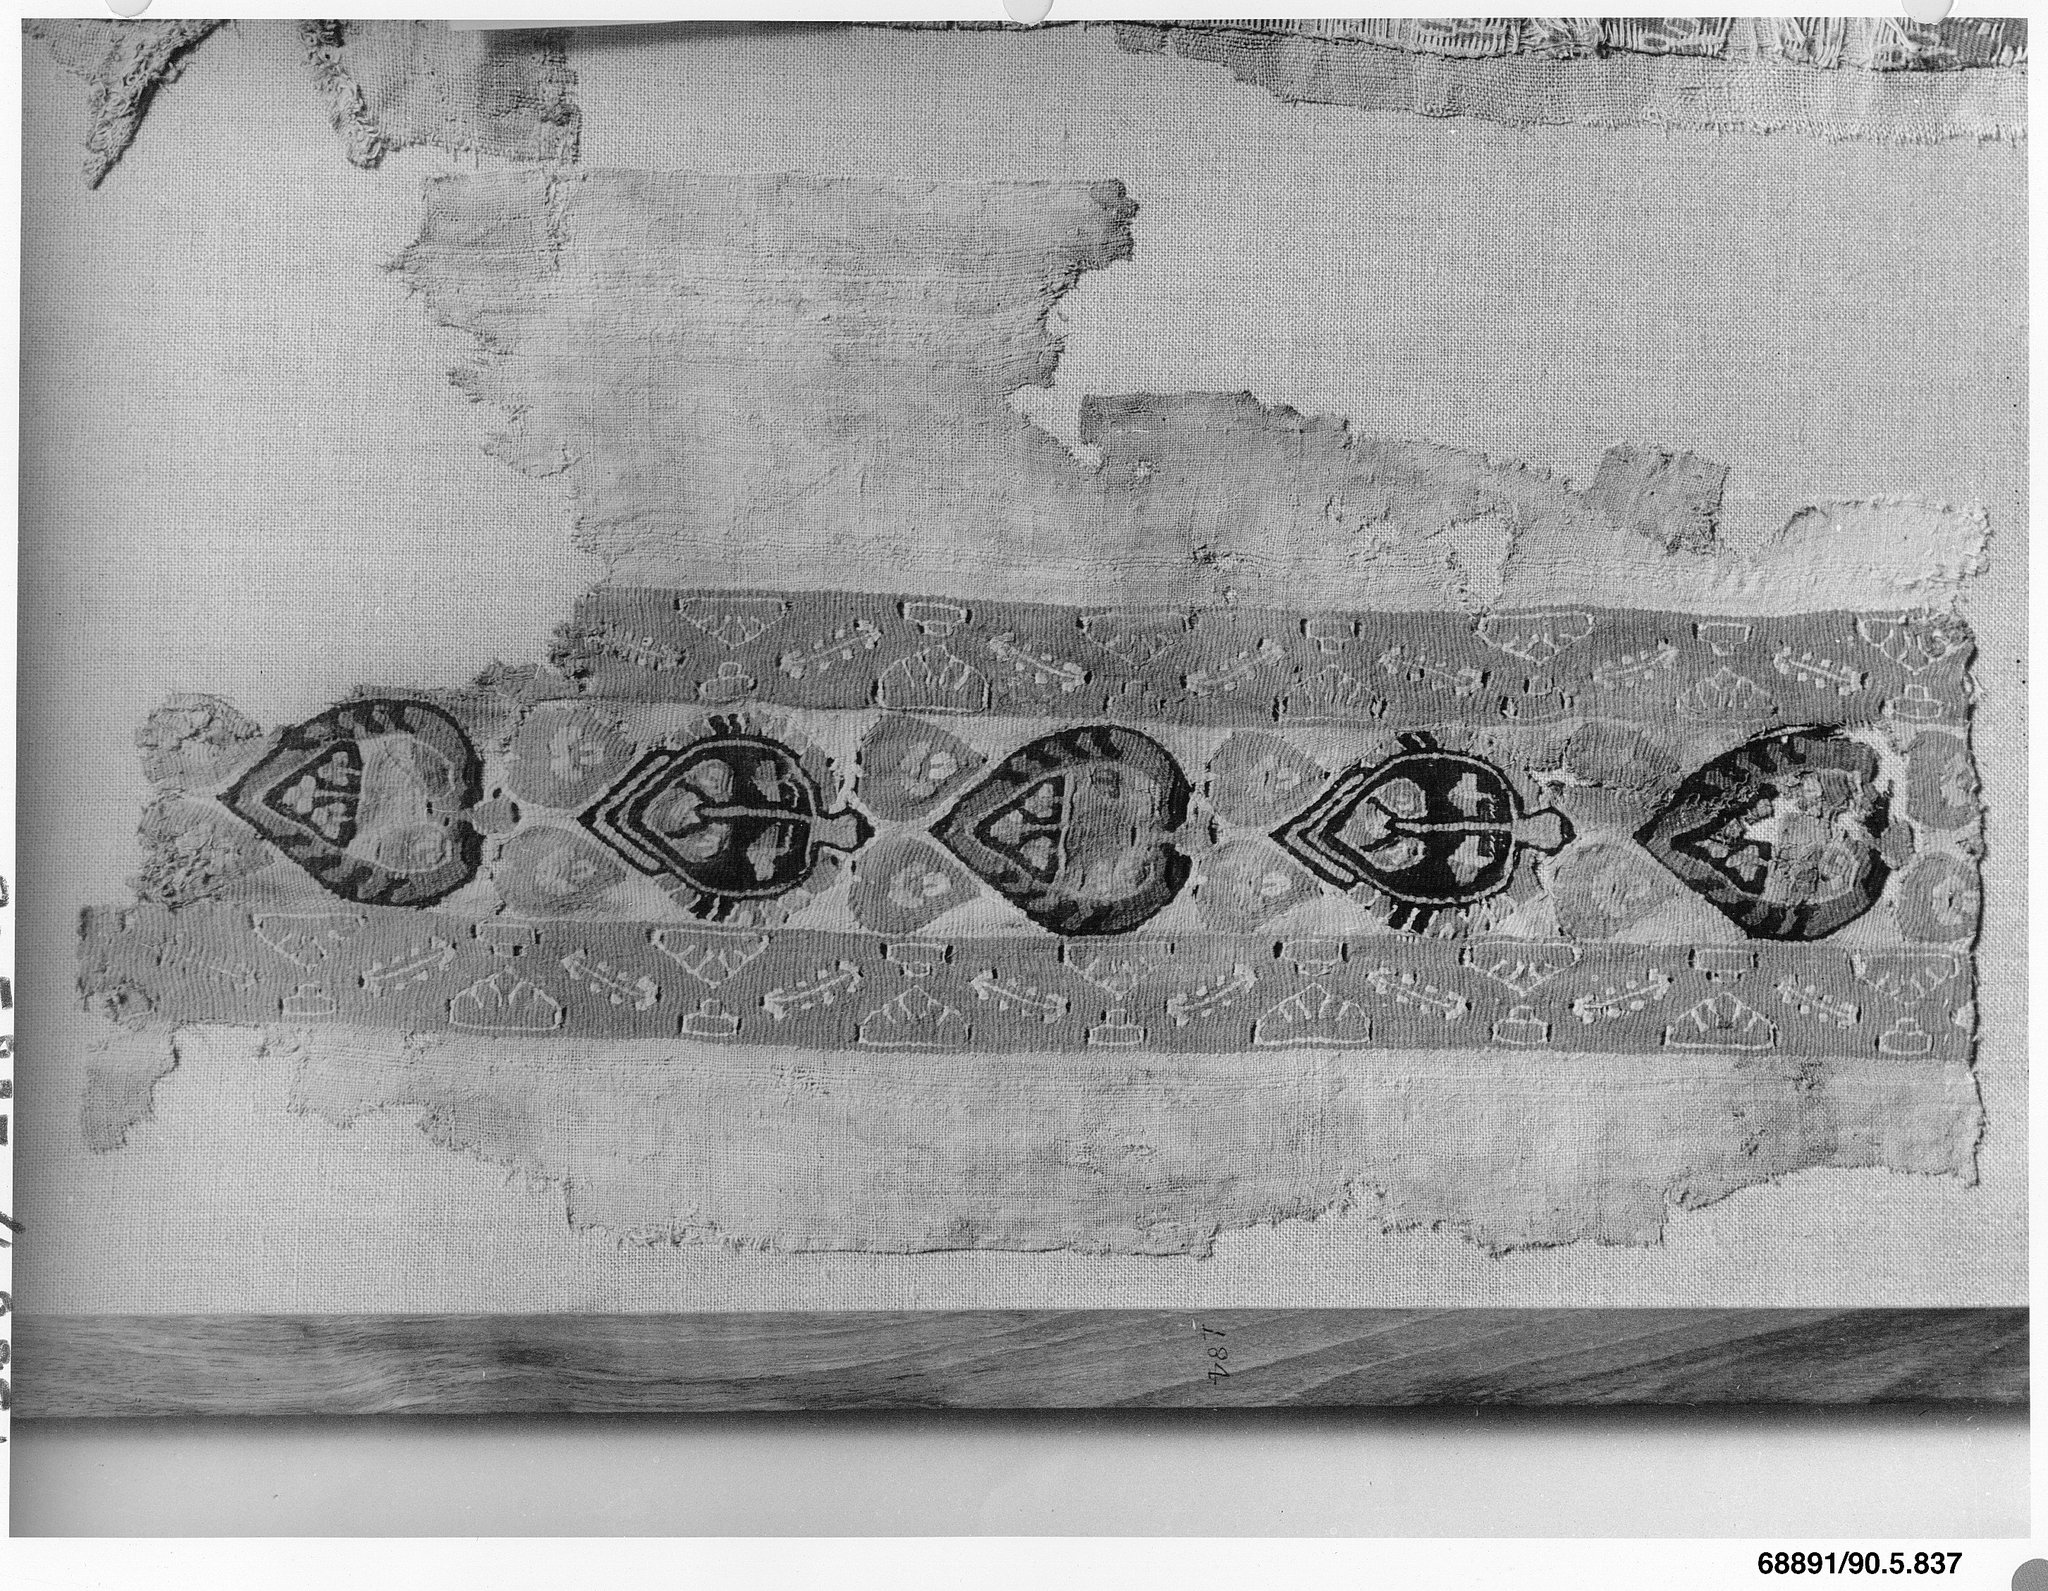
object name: band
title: Band with Vegetal Ornament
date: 601-800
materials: linen, wool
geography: egypt